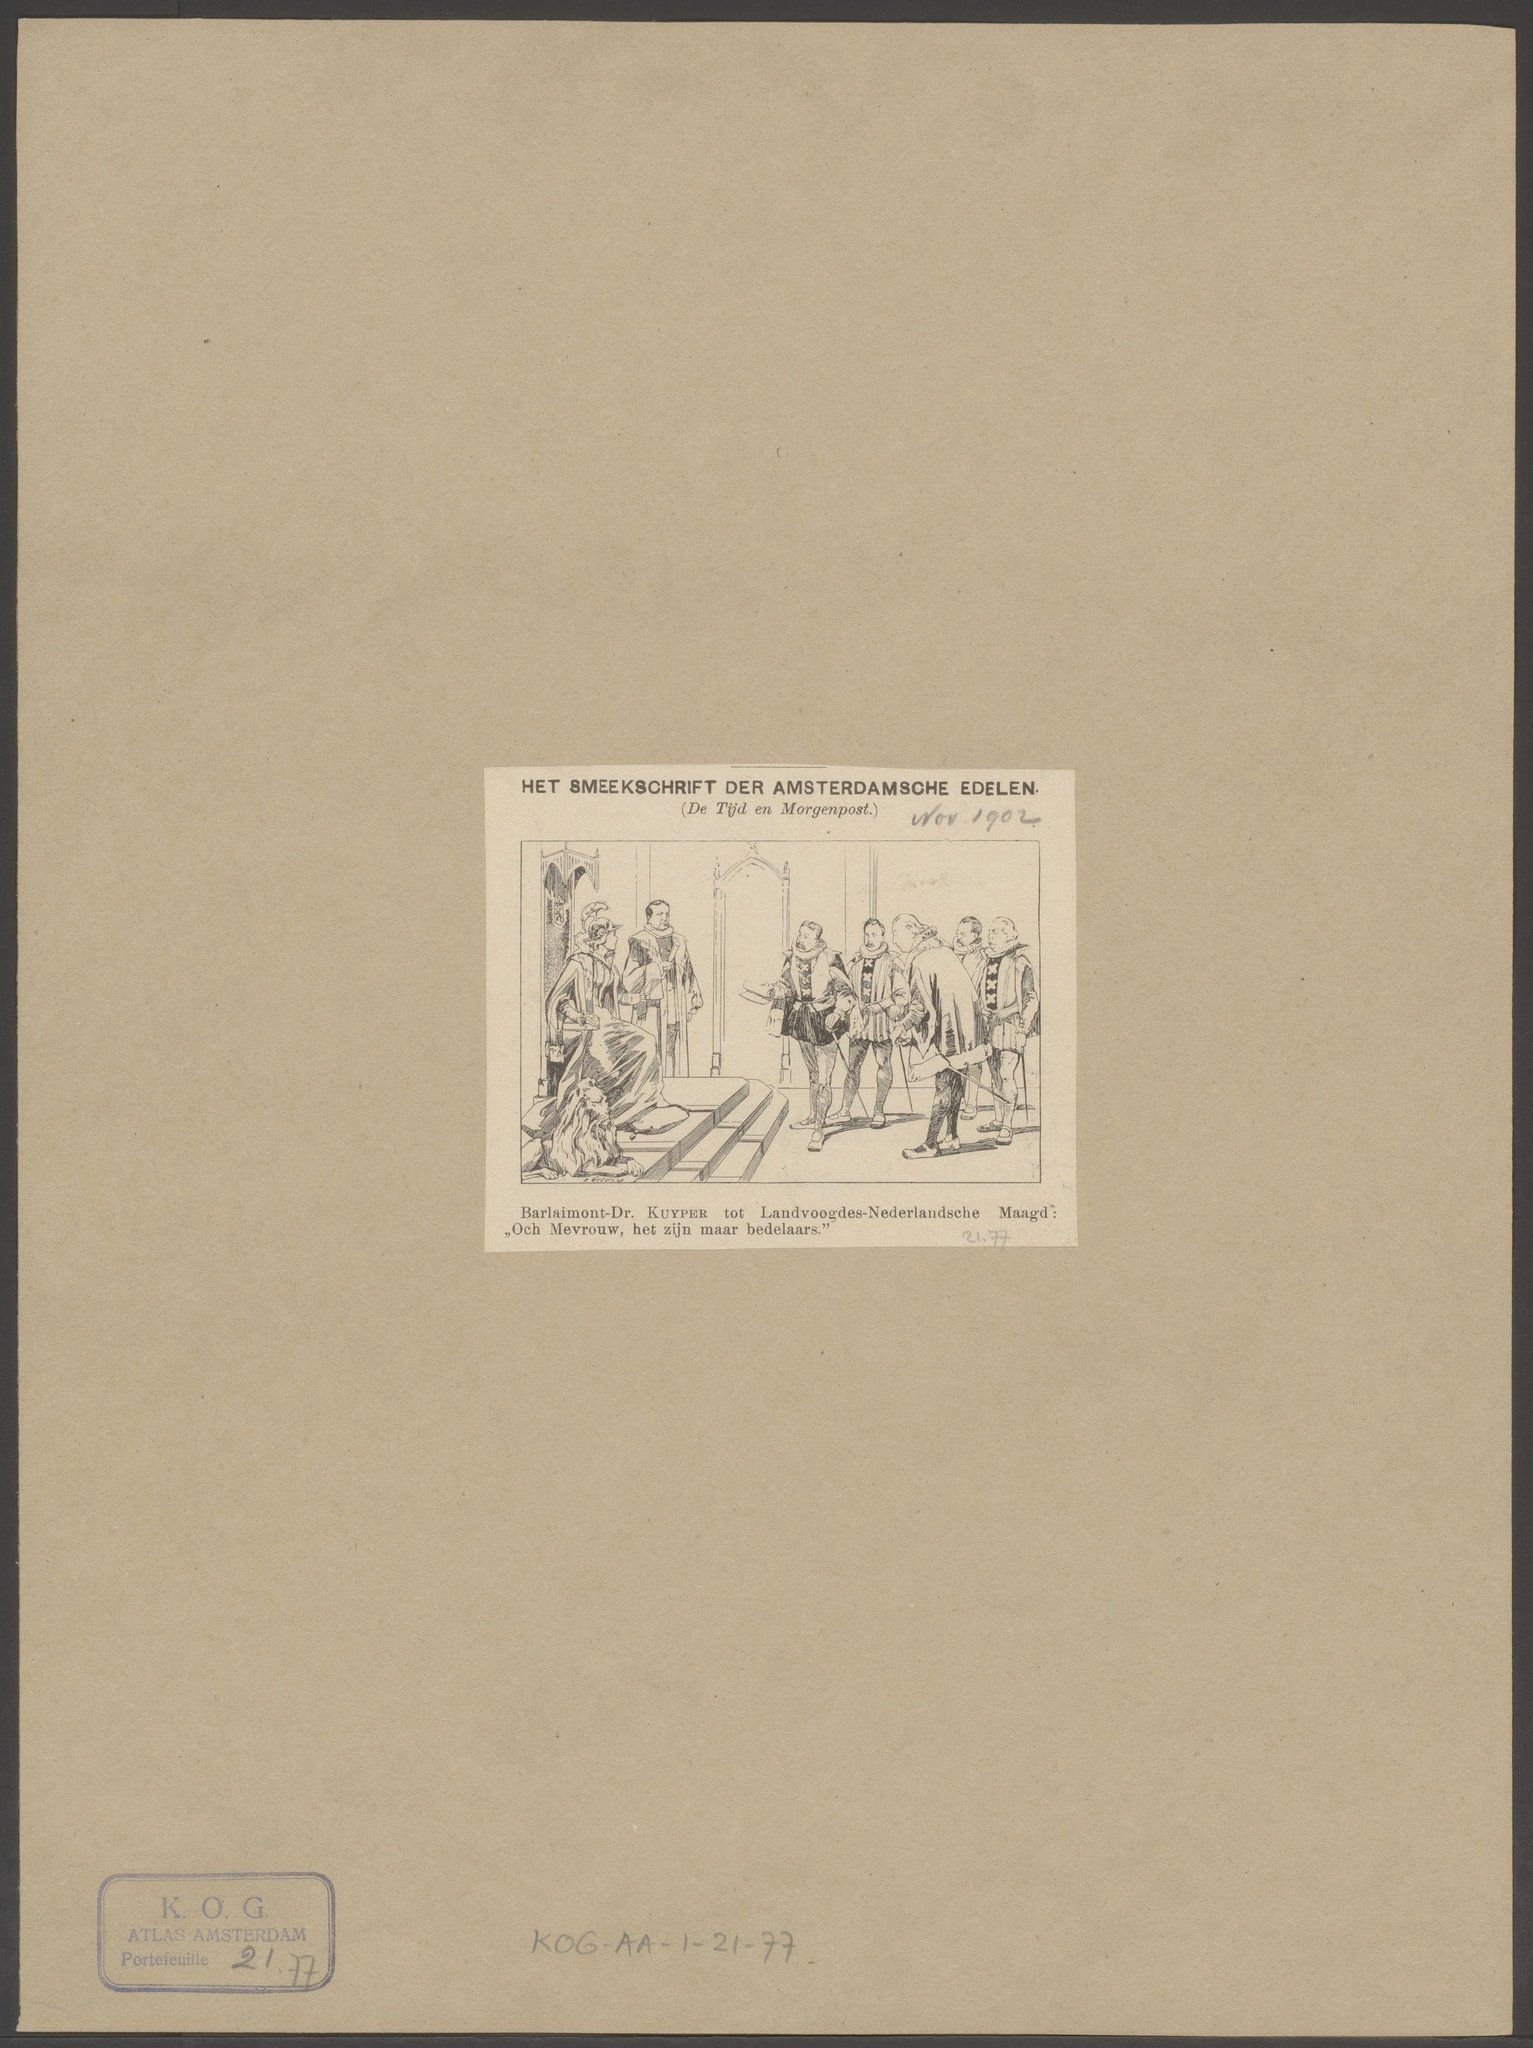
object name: newspaper clipping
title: Spotprent op de Amsterdamse gemeenteraad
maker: petrus van geldorp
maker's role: draughtsman, print maker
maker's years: 1872-1939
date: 1902-1911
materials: paper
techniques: letterpress printing, line block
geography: netherlands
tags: amsterdam, utrecht, politician, jacob nicolaas van hall, surabaya, mayor, personification of a city, town-patron(ess), ruler, sovereign - bb - female ruler, politician, e.g. party leader, political caricatures and satires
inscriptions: collector's mark: Lugt 1641b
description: Koningin Wilhelmina afgebeeld als Margaretha van Parma, minister-president Abraham Kuyper als Charles de Berlaymont, en de gemeenteraadslieden van Amsterdam als edelen. Onderwerpsrubriek binnen de Atlas Amsterdam: Financiën.